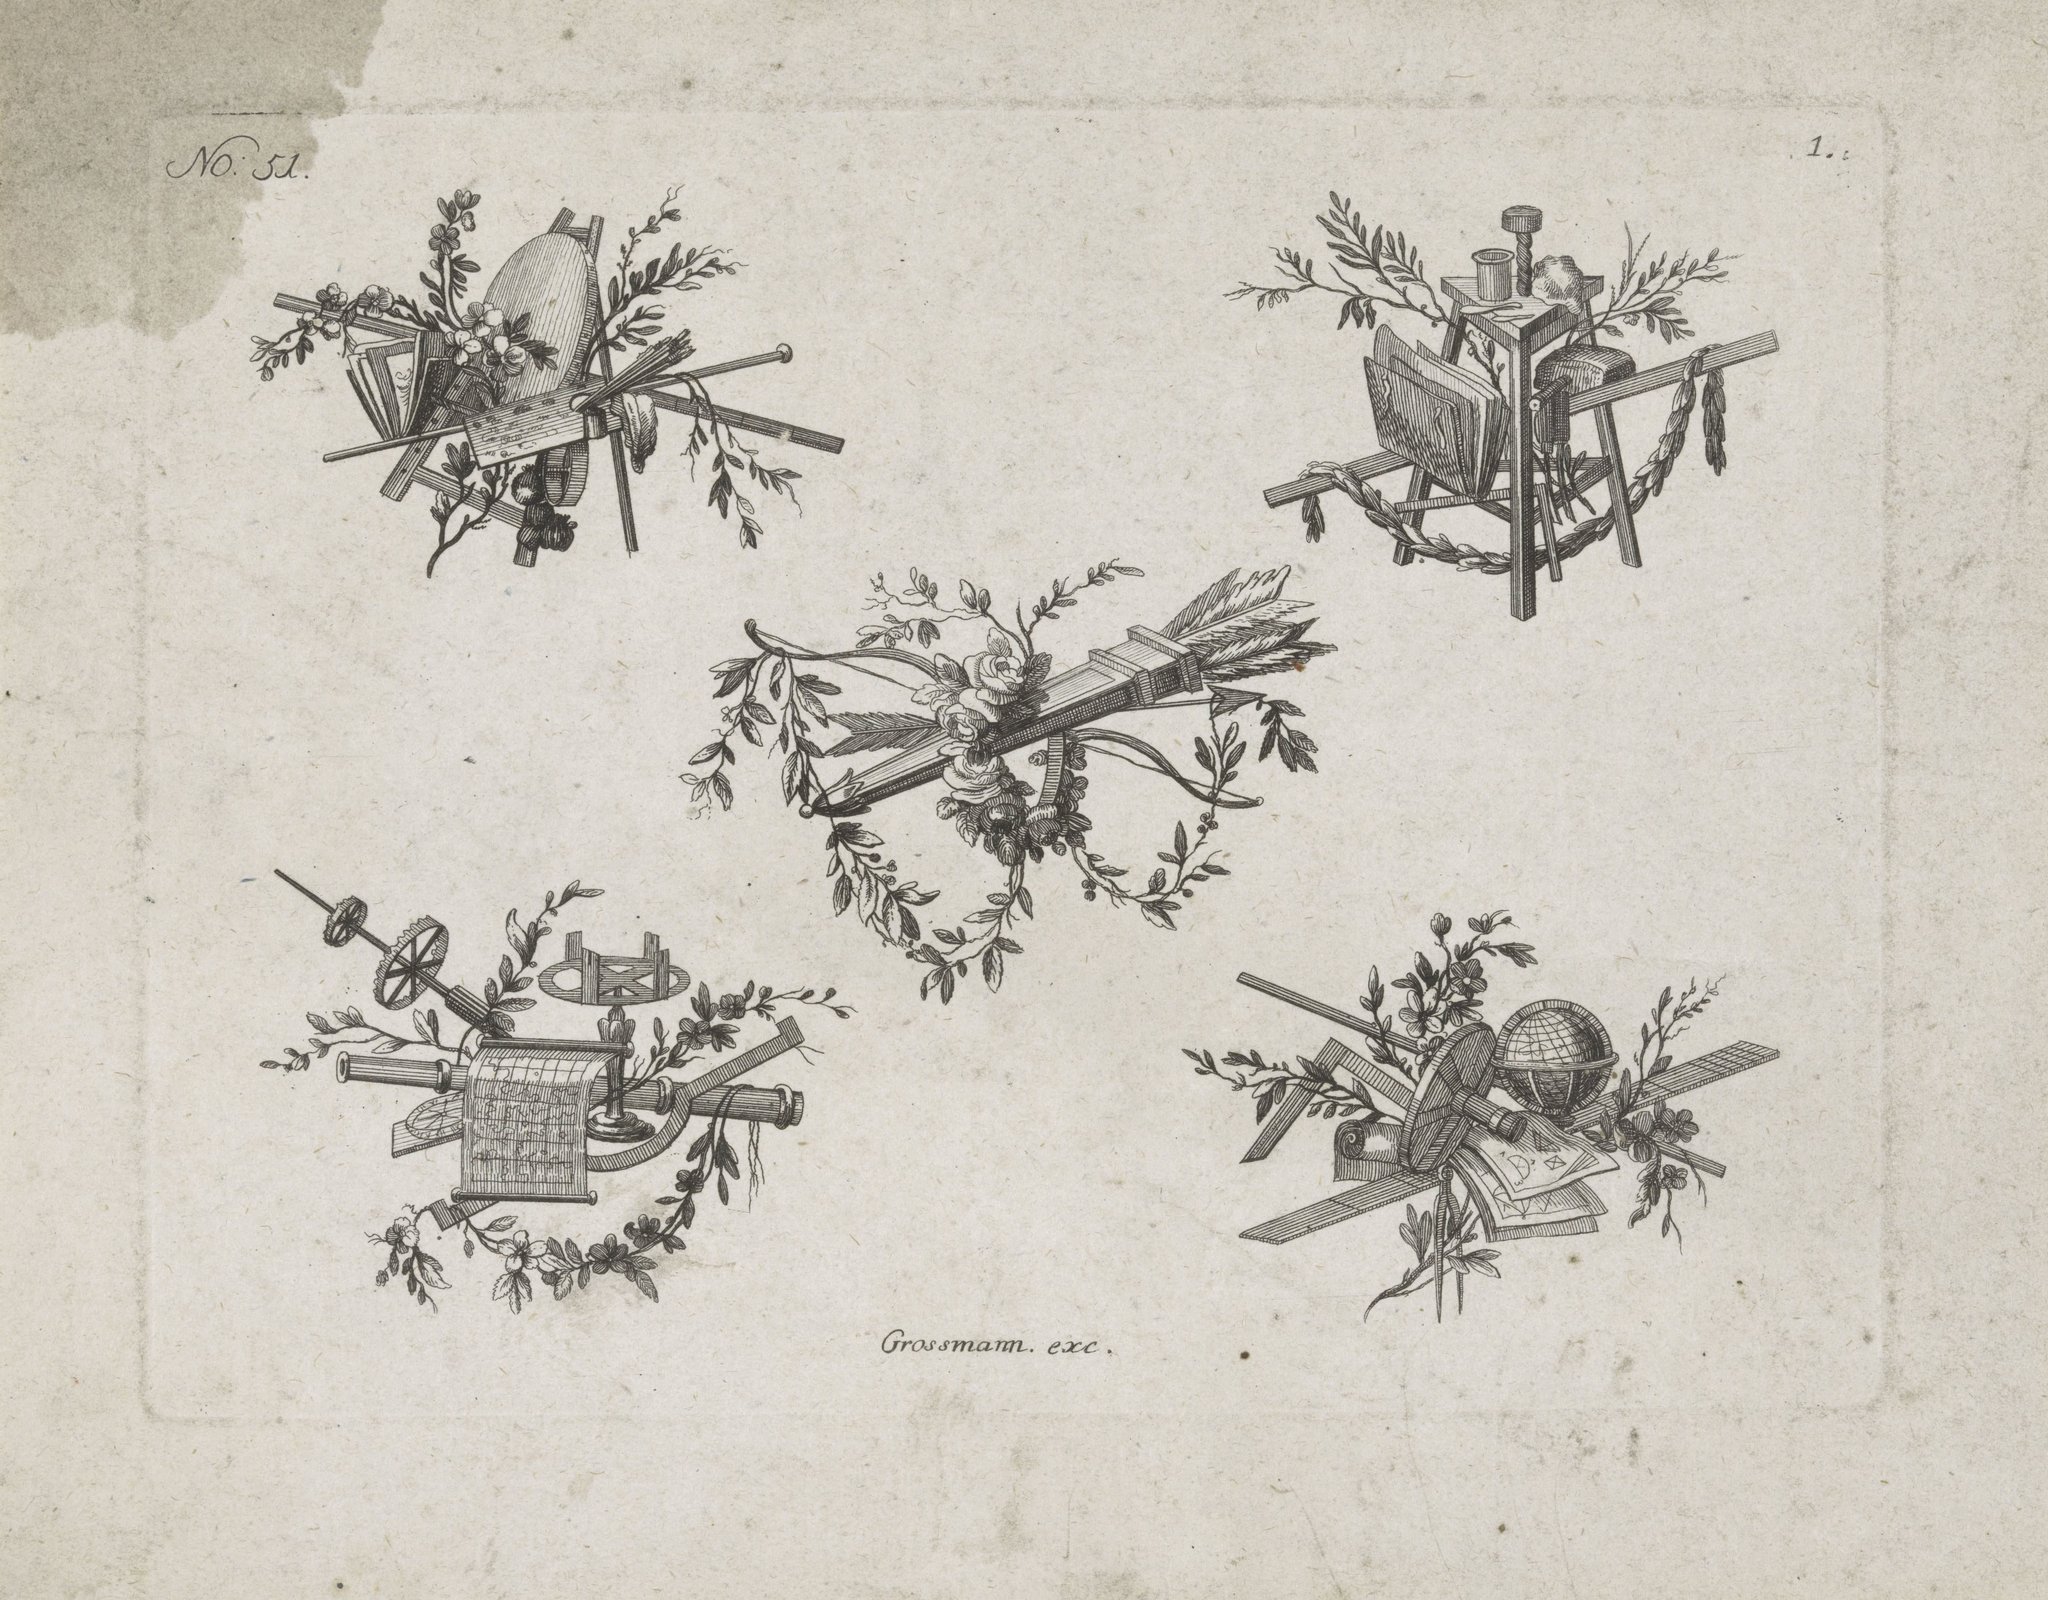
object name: print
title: Trofeeën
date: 1751-1798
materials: paper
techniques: etching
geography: augsburg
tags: quiver, symbolic representations, allegories and emblems ~ applied arts, symbolic representations, allegories and emblems ~ science, 'scientia'; 'scienza', 'studio' (ripa)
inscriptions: collector's mark: Lugt 2228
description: Vijf trofeeën met attributen van kunsten en wetenschappen. Links boven schilderkunst, rechts boven beeldhouwkunst, in het midden een pijl, boog en pijlenkoker, links onder meetkunde, rechts onder rekenkunde. Uitgeversnummer 51.